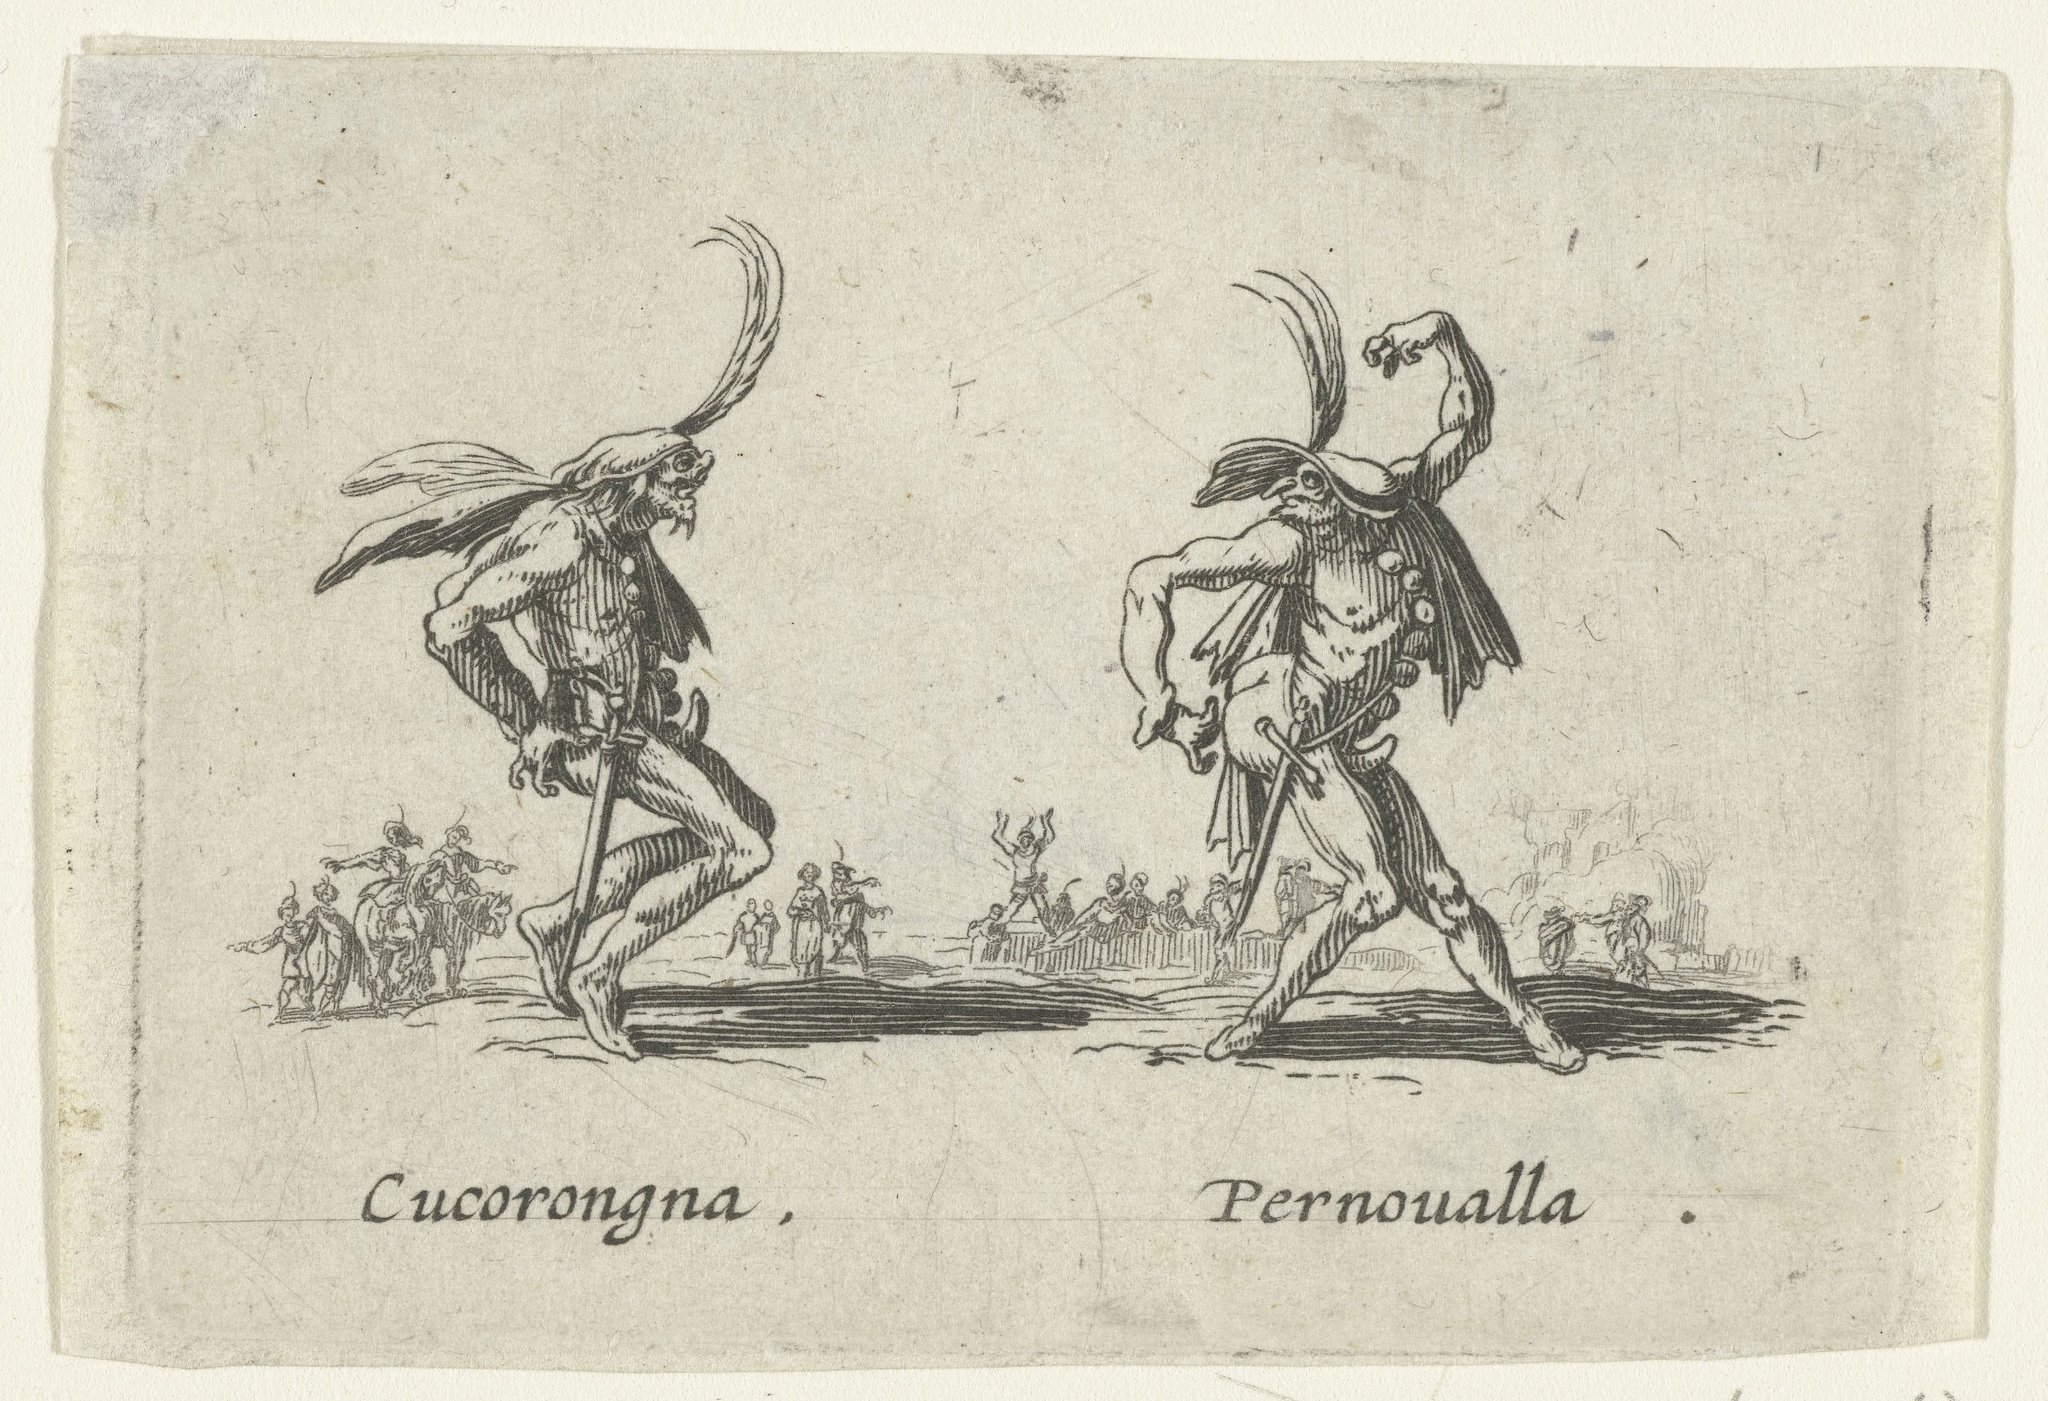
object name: print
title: Twee straatartiesten als Cucorongna en Pernoualla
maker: Anonymous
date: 1622-1670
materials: paper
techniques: etching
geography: low countries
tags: types in 'commedia dell'arte', dancing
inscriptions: collector's mark: Lugt 2228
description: Twee artiesten met gevederde hoofddeksels op dansen naast elkaar. Onder de figuren staan hun namen genoteerd. Deze prent is onderdeel van een serie van 23 prenten (24 incl. titelprent) met telkens op de voorgrond twee straatartiesten verkleed als figuren uit de Italiaanse commedia dell'arte, en op de achtergrond toeschouwers die in de buitenlucht een (dans)voorstelling van straatartiesten gadeslaan.